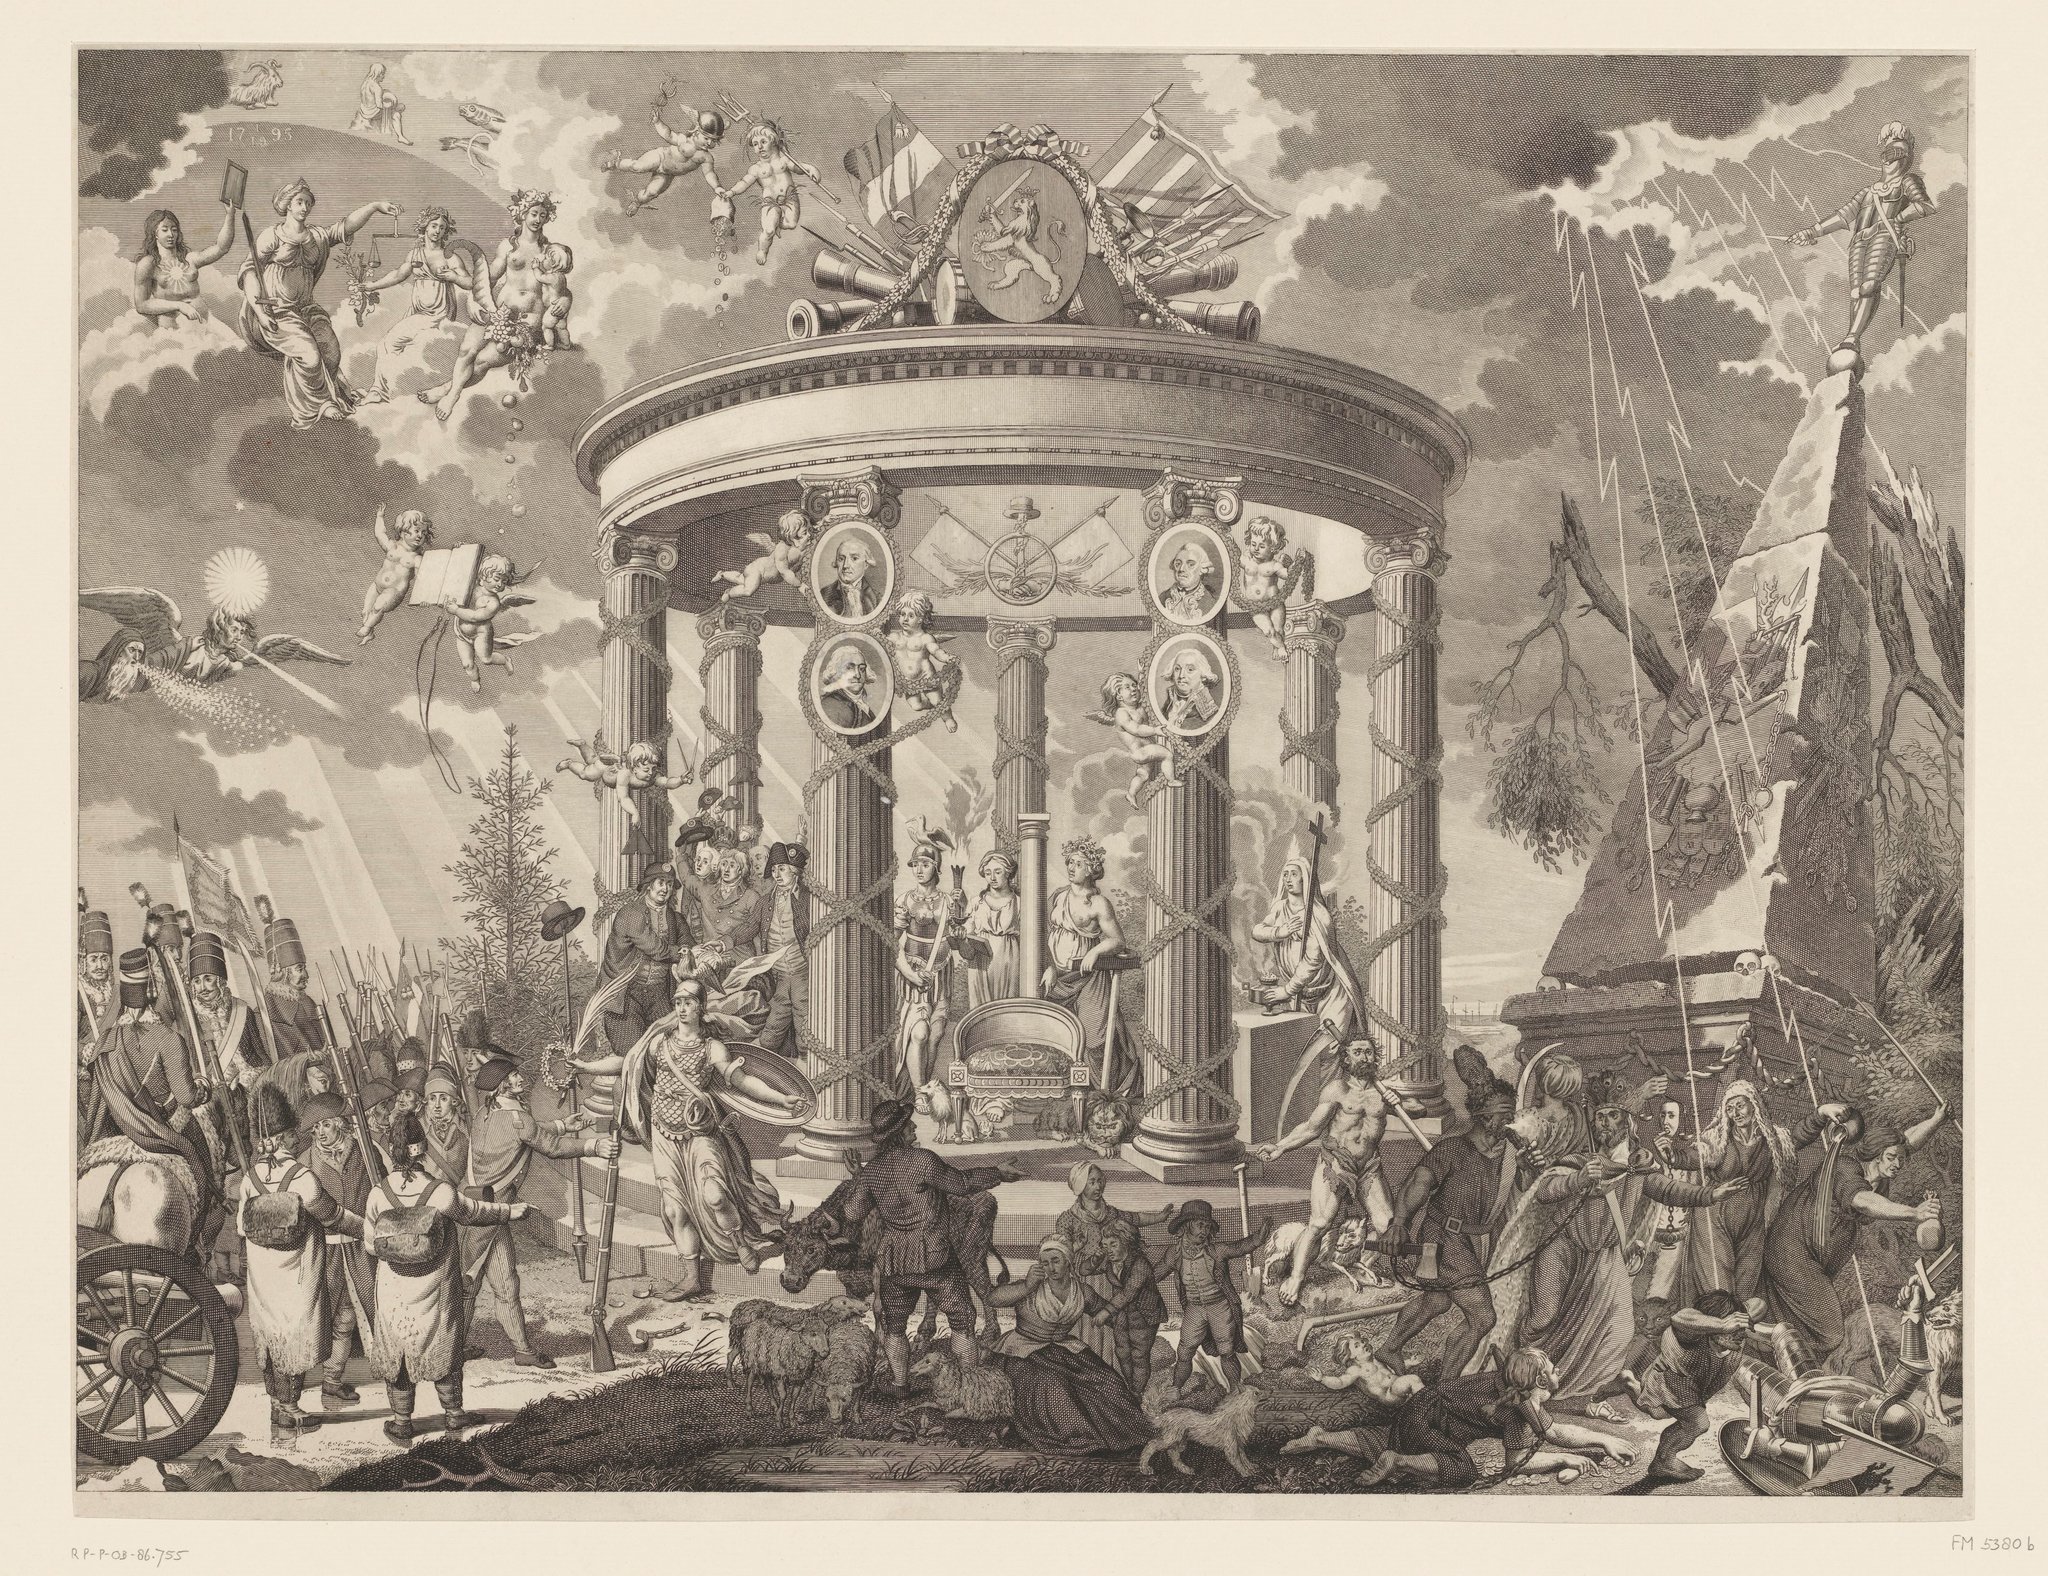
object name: print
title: Tempel van de Bataafse Vrijheid, 1795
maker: jan gerritsz. visser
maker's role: print maker, publisher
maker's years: 1745-1821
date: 1795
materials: paper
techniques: engraving, etching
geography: netherlands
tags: the hague, johan arnold zoutman, herman willem daendels, politician, joan derk van der capellen tot den pol, paris, jan willem de winter, freedom, liberty; 'libertà' (ripa) (+ abstract concept represented by female figure)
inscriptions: collector's mark: Lugt 2228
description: Allegorie op de Vrijheid, 1795. De Bataafse Vrijheid treedt uit een open tempel om de Franse troepen, die over het ijs aankomen, te verwelkomen. Aan de zuilen van de tempel hangen portretten van verdienstelijke Patriotten. De zetel van de Nationale Conventie is leeg. Rechts wordt de zuil met een ridder door bliksem getroffen en valt om. Slavernij, Hoogmoed, Gierigheid en Valsheid vluchten.